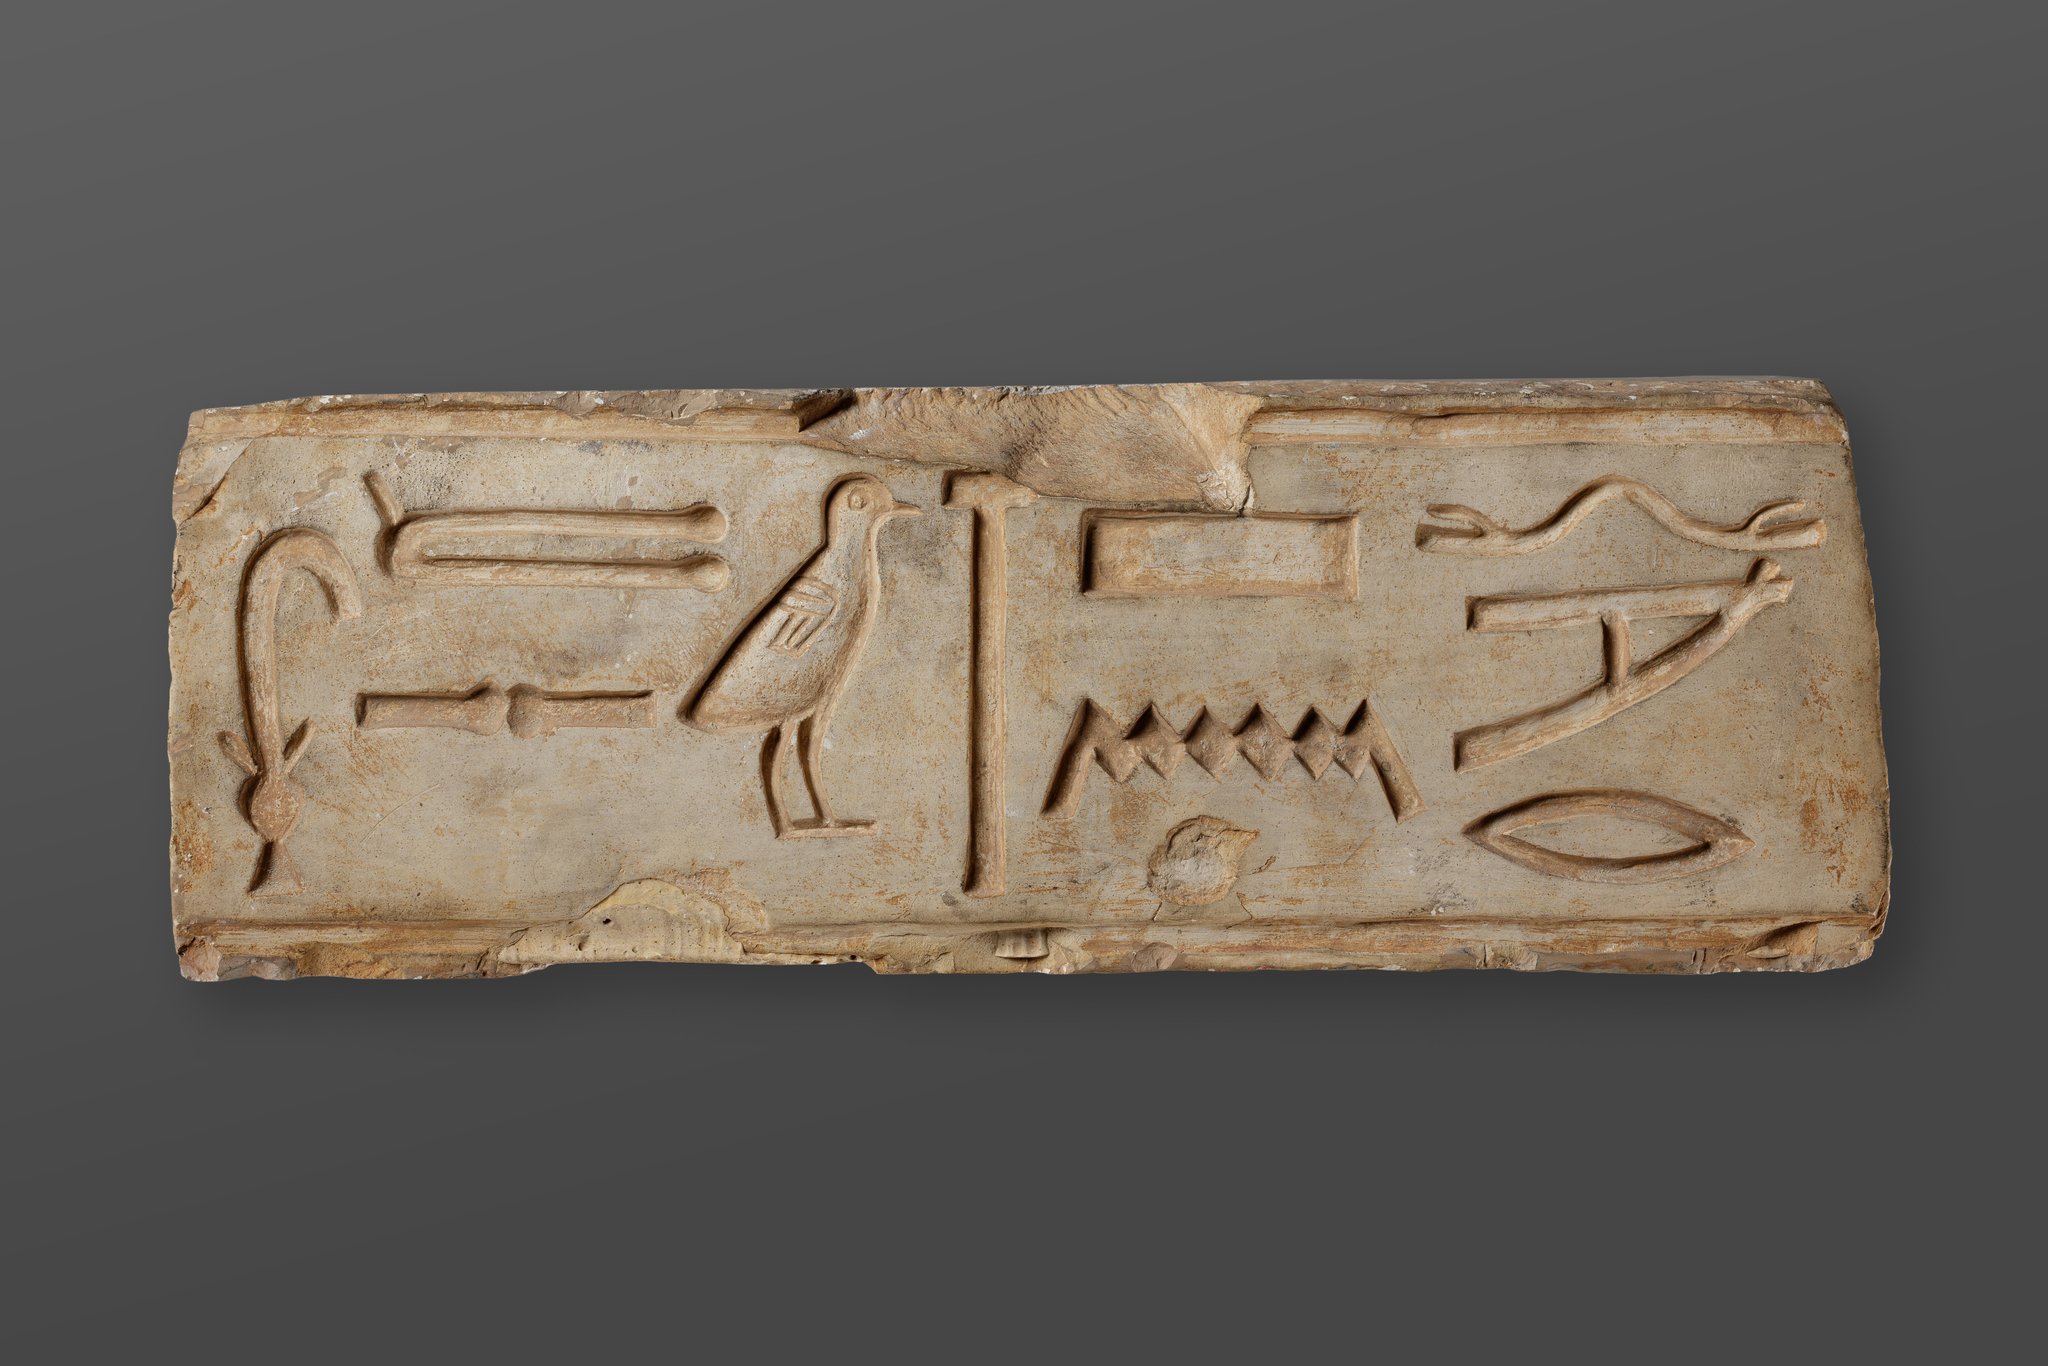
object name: relief fragment, tomb of mereri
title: Frieze from the tomb of Mereri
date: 2100-2030 BCE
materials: limestone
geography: egypt